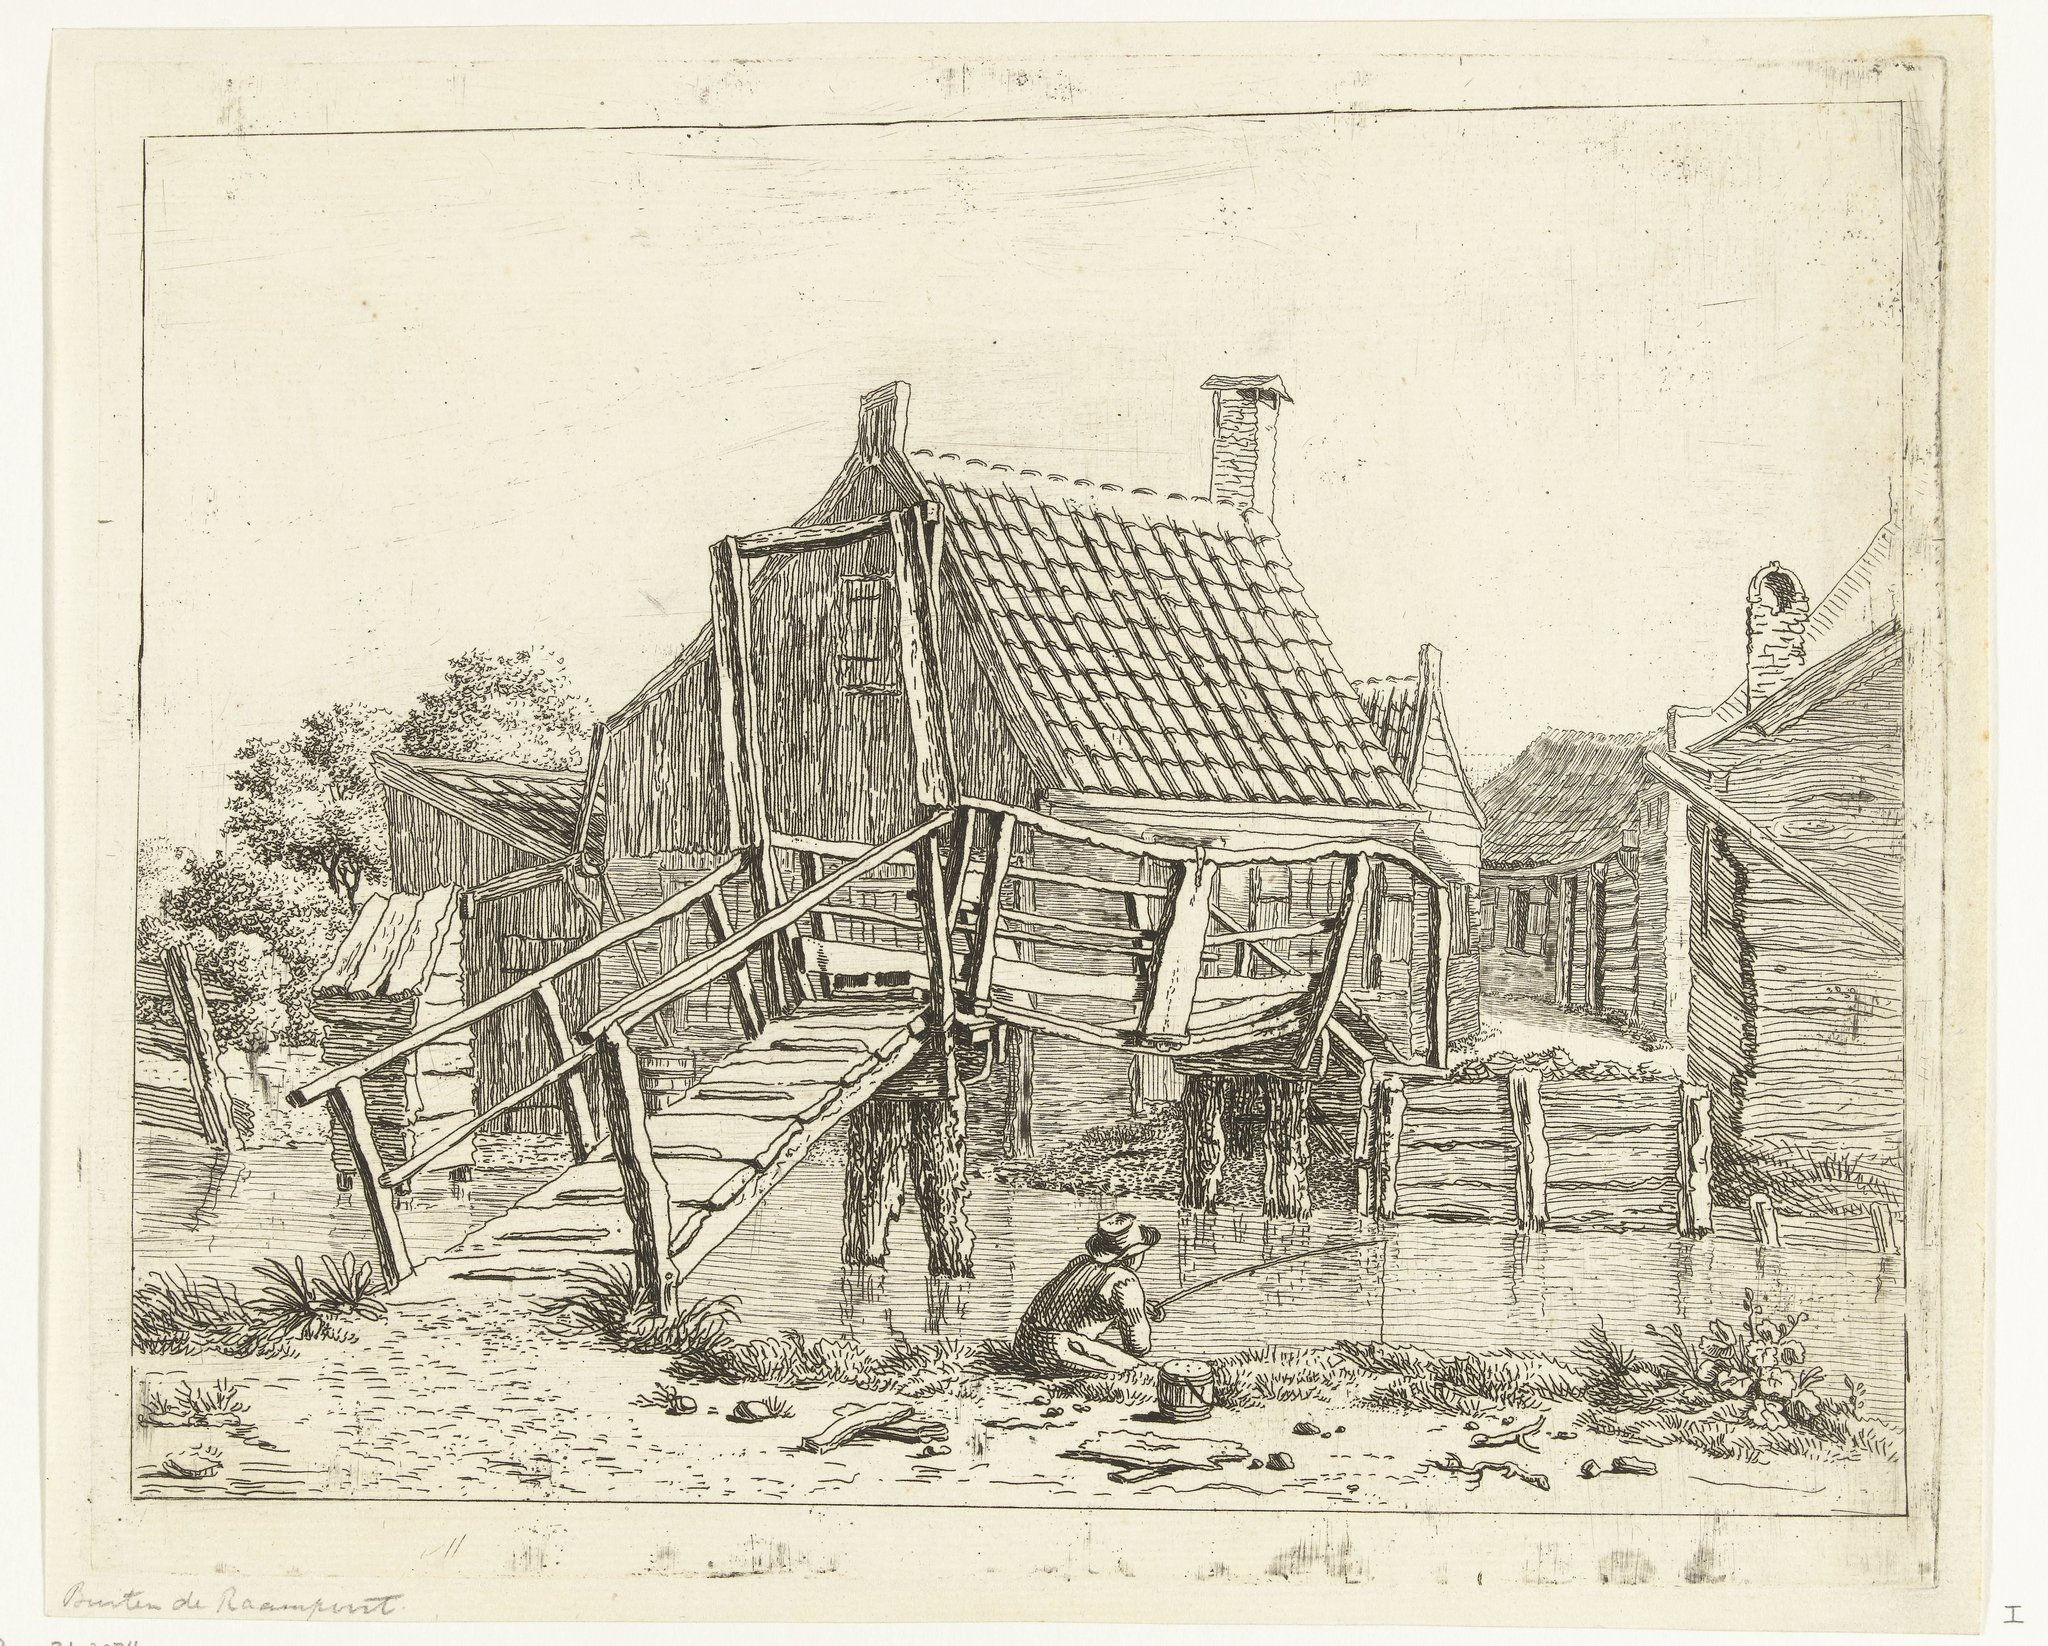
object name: print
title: Buiten de Raampoort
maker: anthonie van den bos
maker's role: draughtsman, print maker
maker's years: 1763-1838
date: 1778-1838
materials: paper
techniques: etching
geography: netherlands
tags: angling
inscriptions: collector's mark: Lugt 2228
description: Een man zit aan de oever van een sloot te hengelen vlakbij een houten brug.